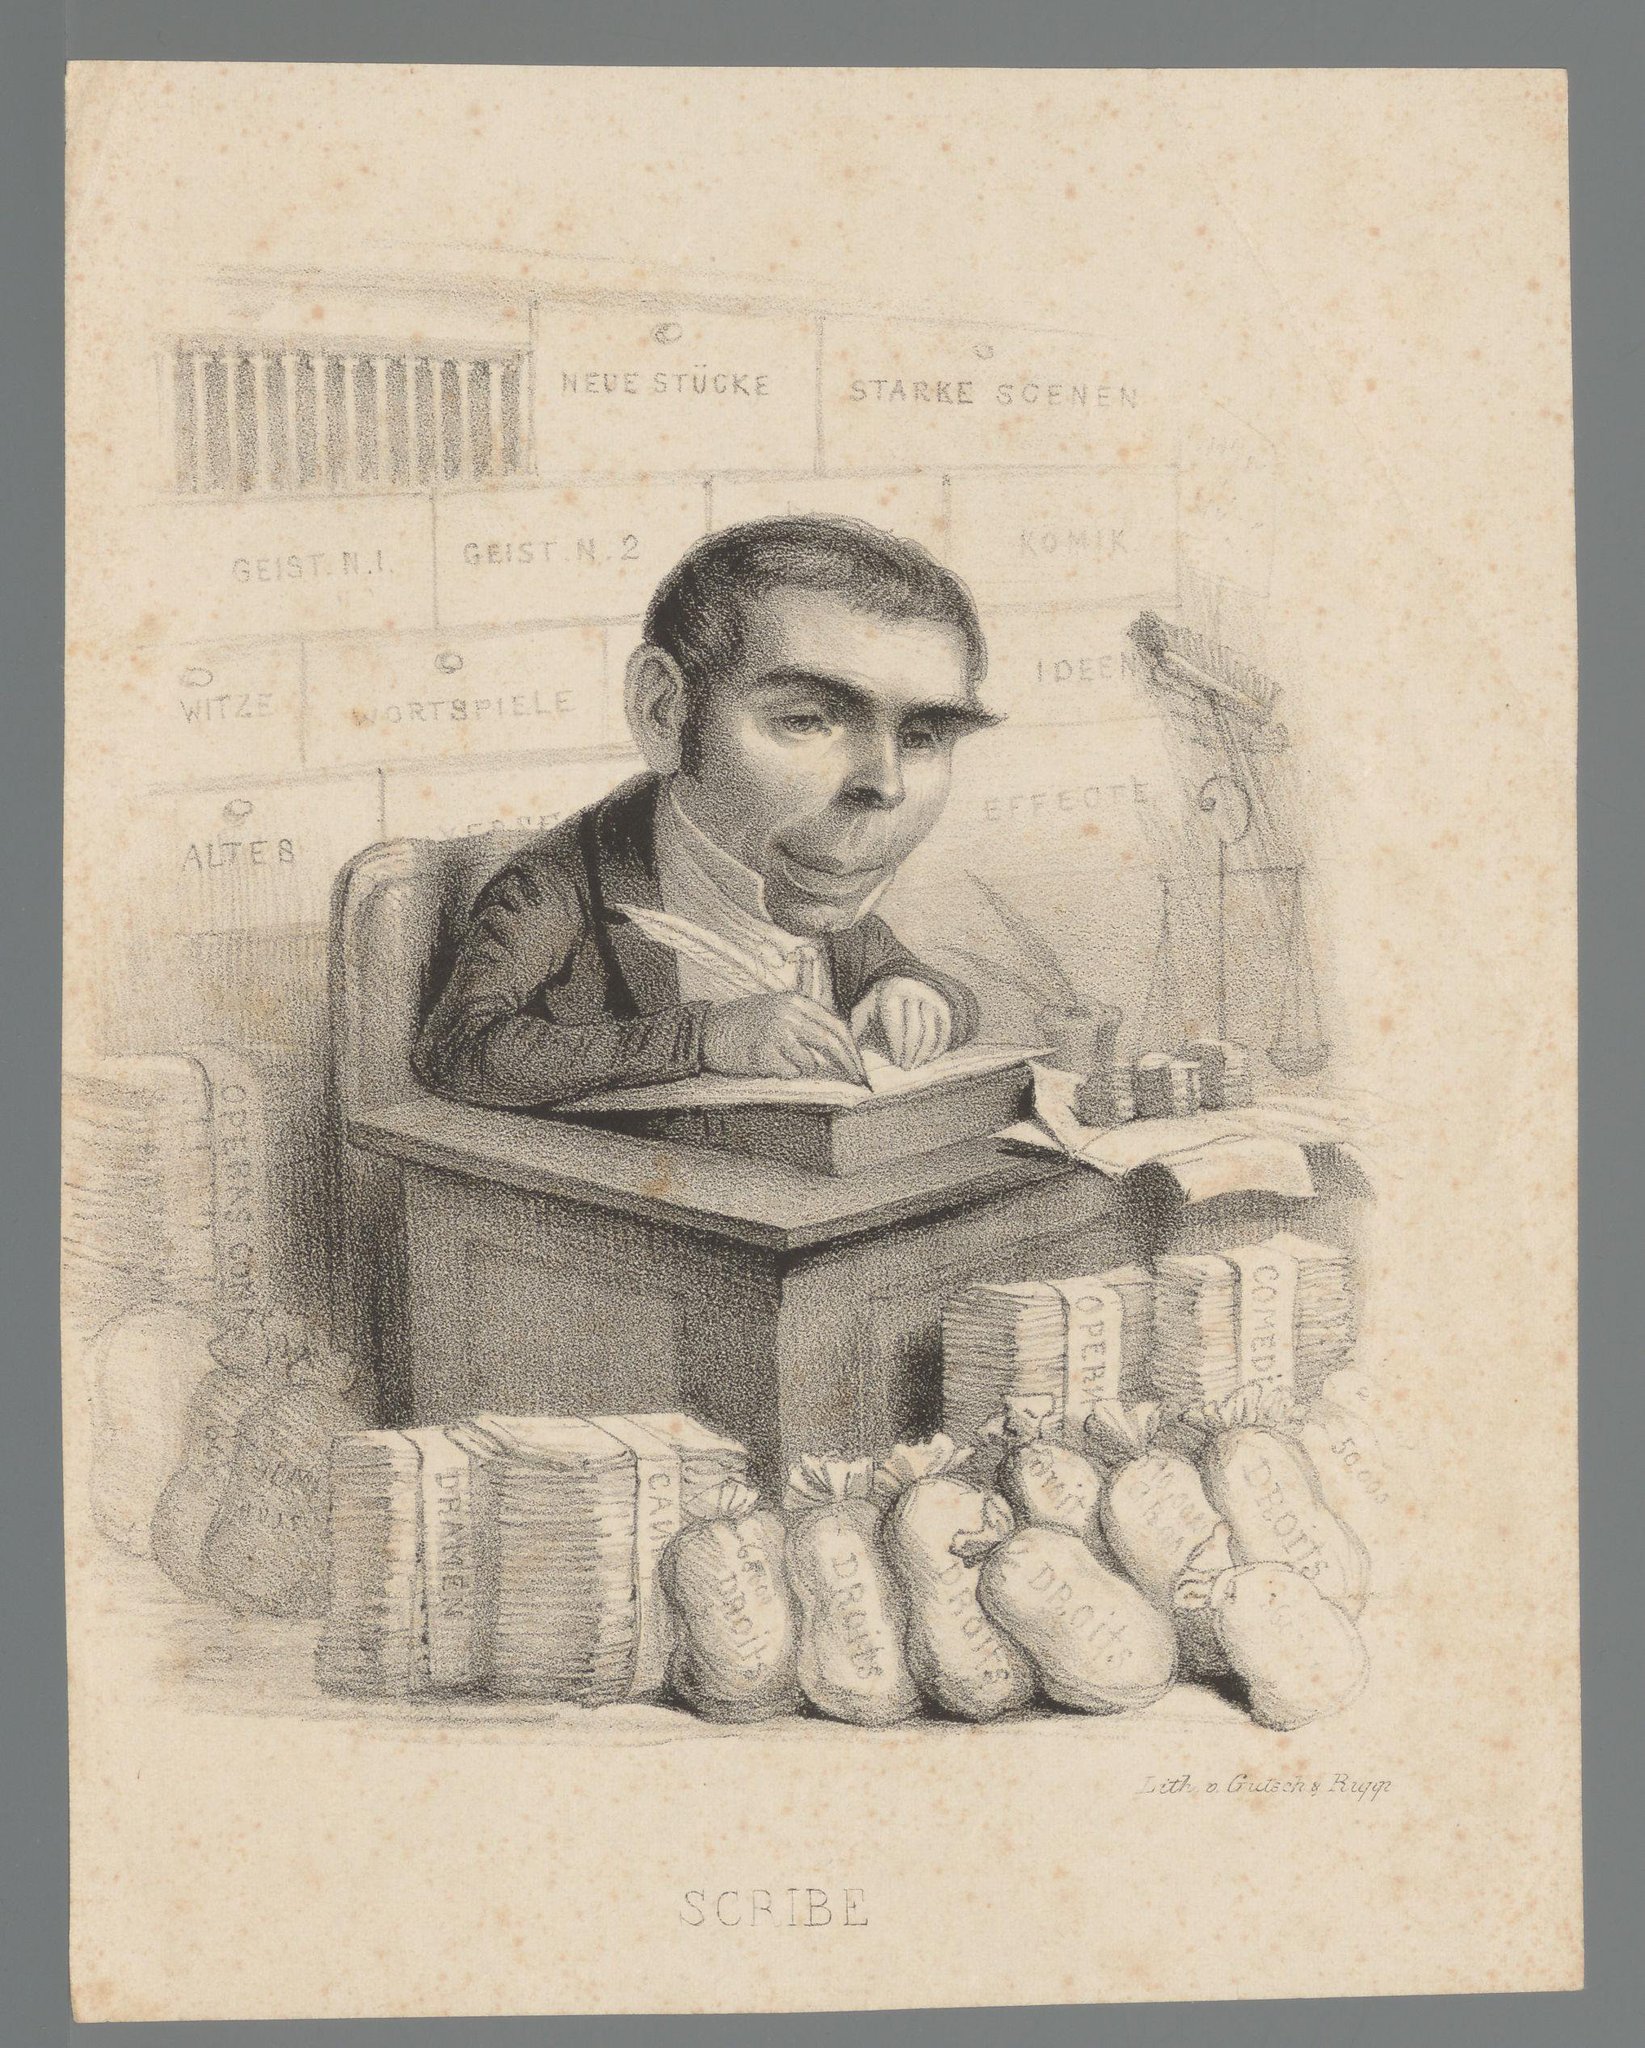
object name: print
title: Karikaturaal portret van Eugène Scribe aan een schrijftafel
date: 1820-1860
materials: paper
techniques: lithograph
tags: historical persons, portrait of a writer, writing accessories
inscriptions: collector's mark: Lugt 2228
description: Rondom de toneelschrijver Scribe liggen stapels en zakken met zijn werken/uitvoeringen, verwijzend naar de hoge productiviteit van zijn hand.